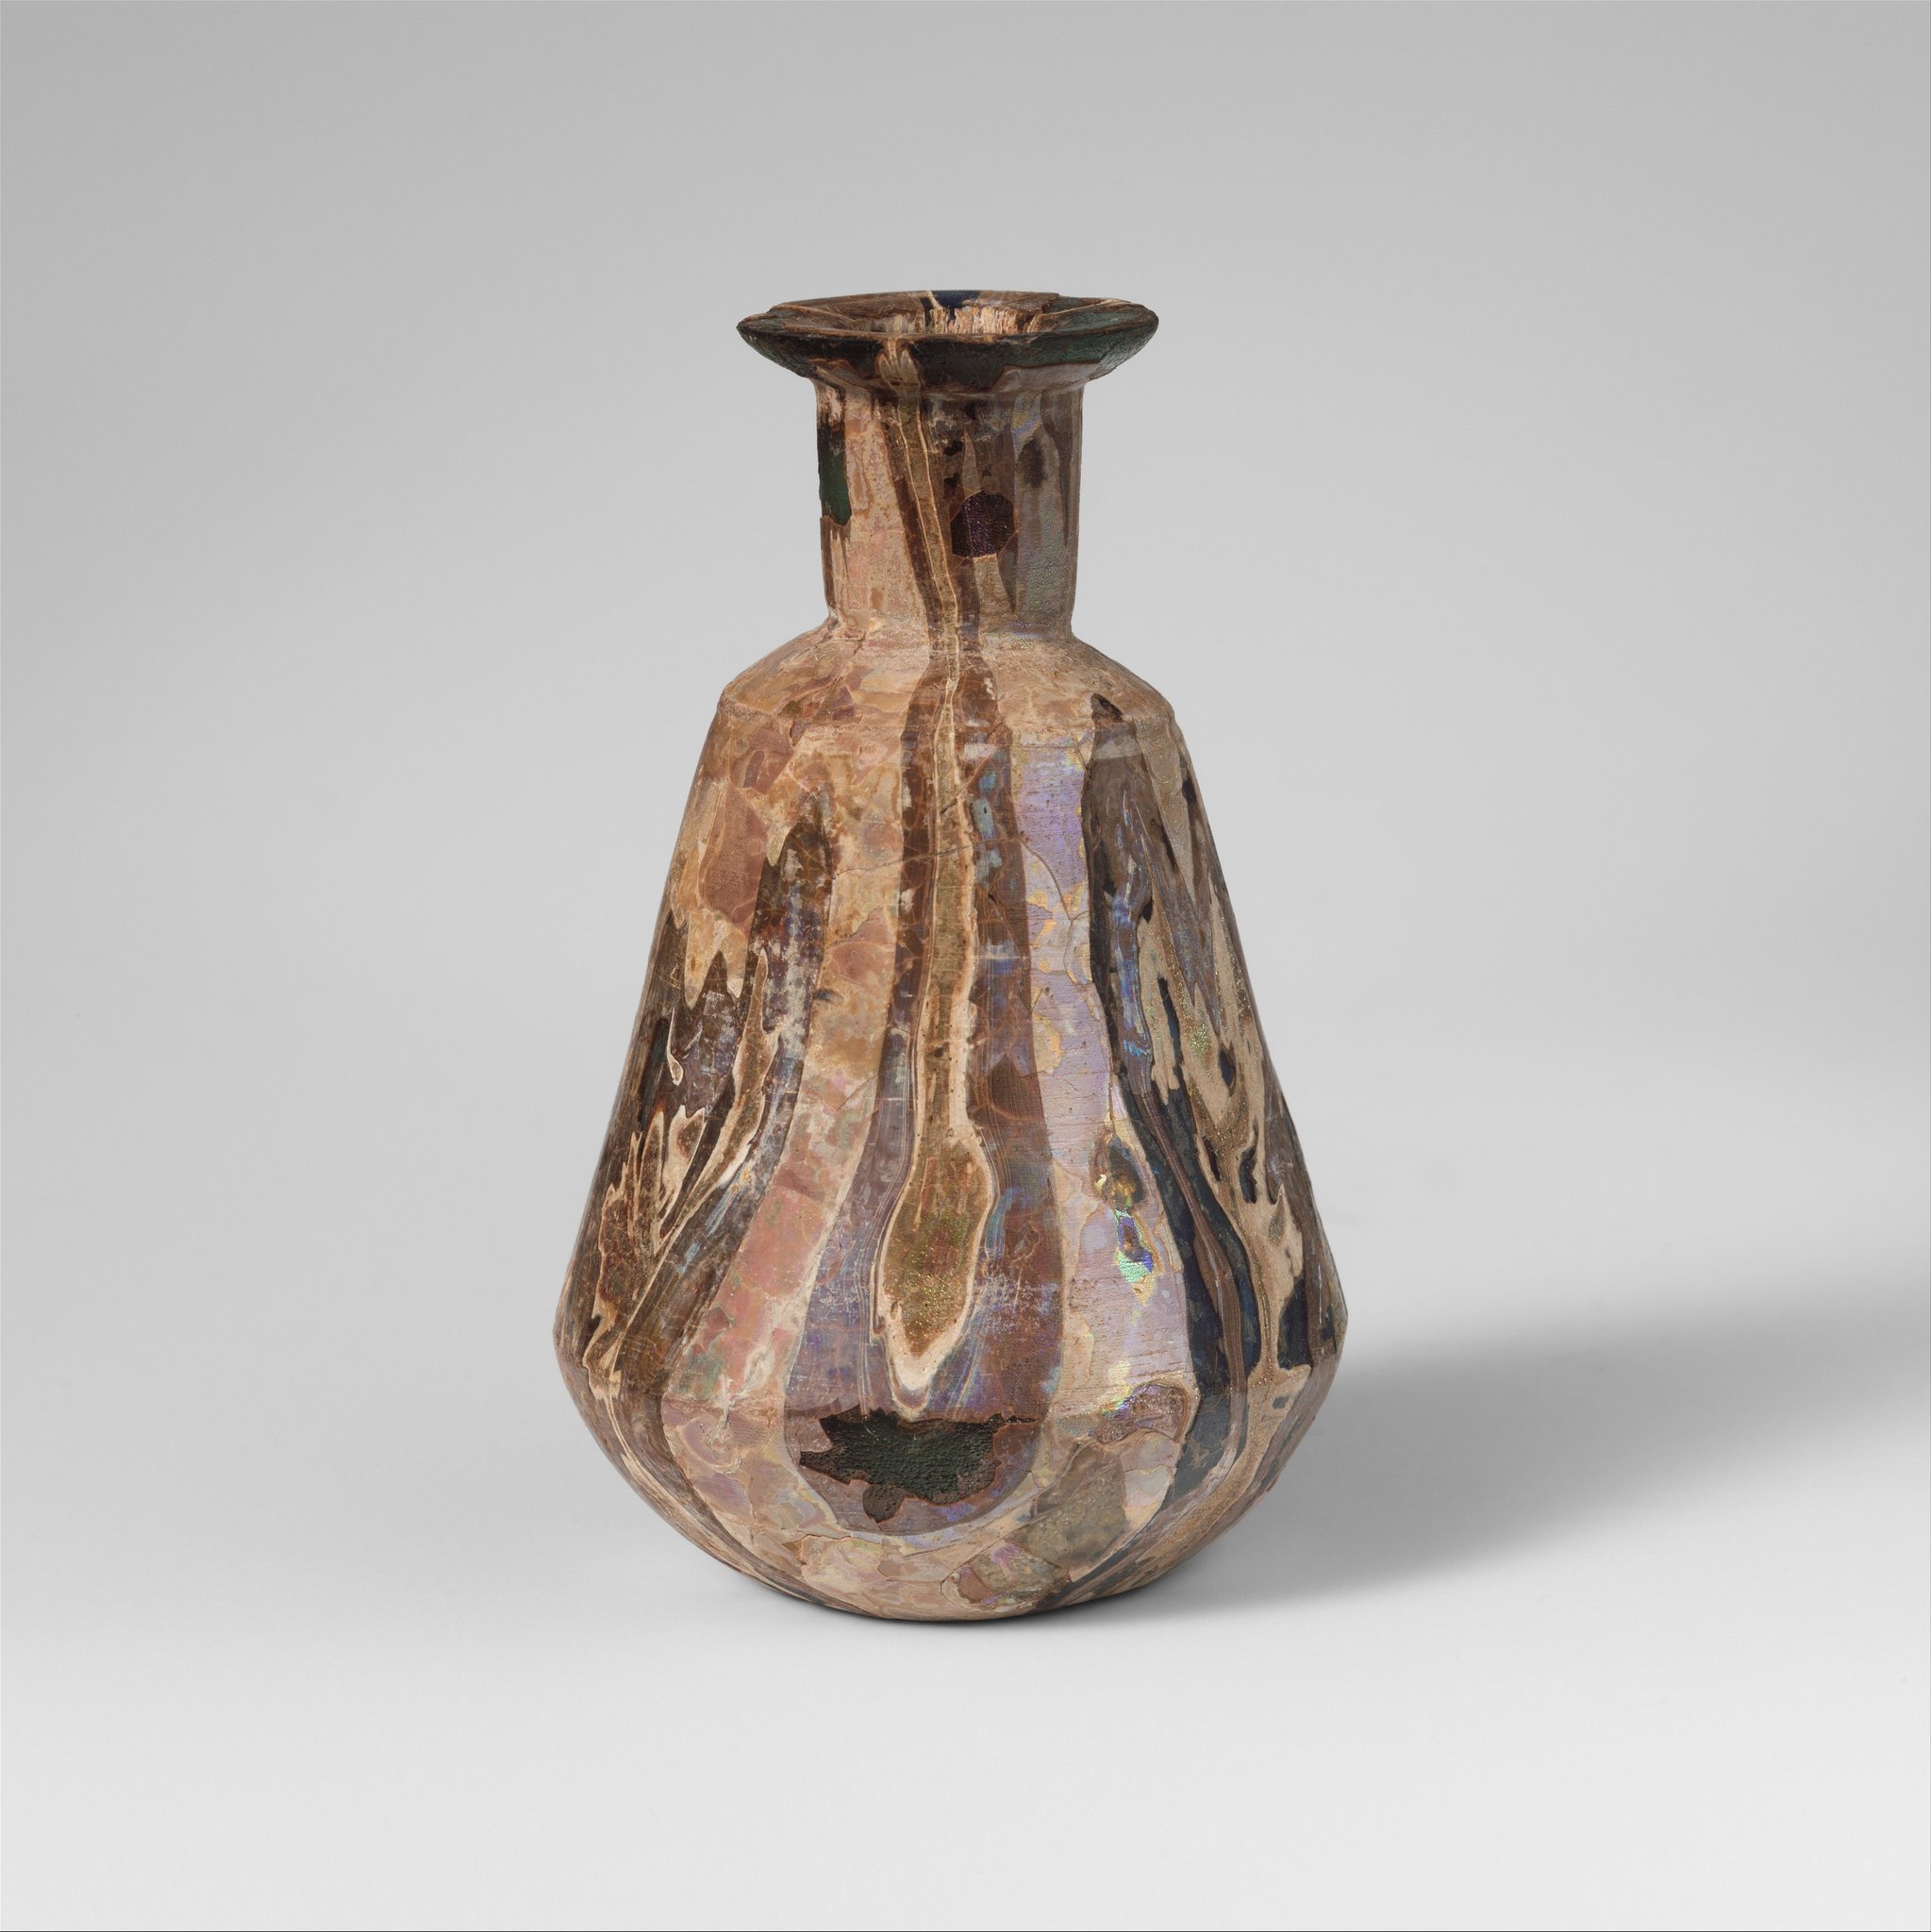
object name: bottle, gold band mosaic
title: Glass gold-band mosaic bottle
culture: roman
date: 1-50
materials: glass